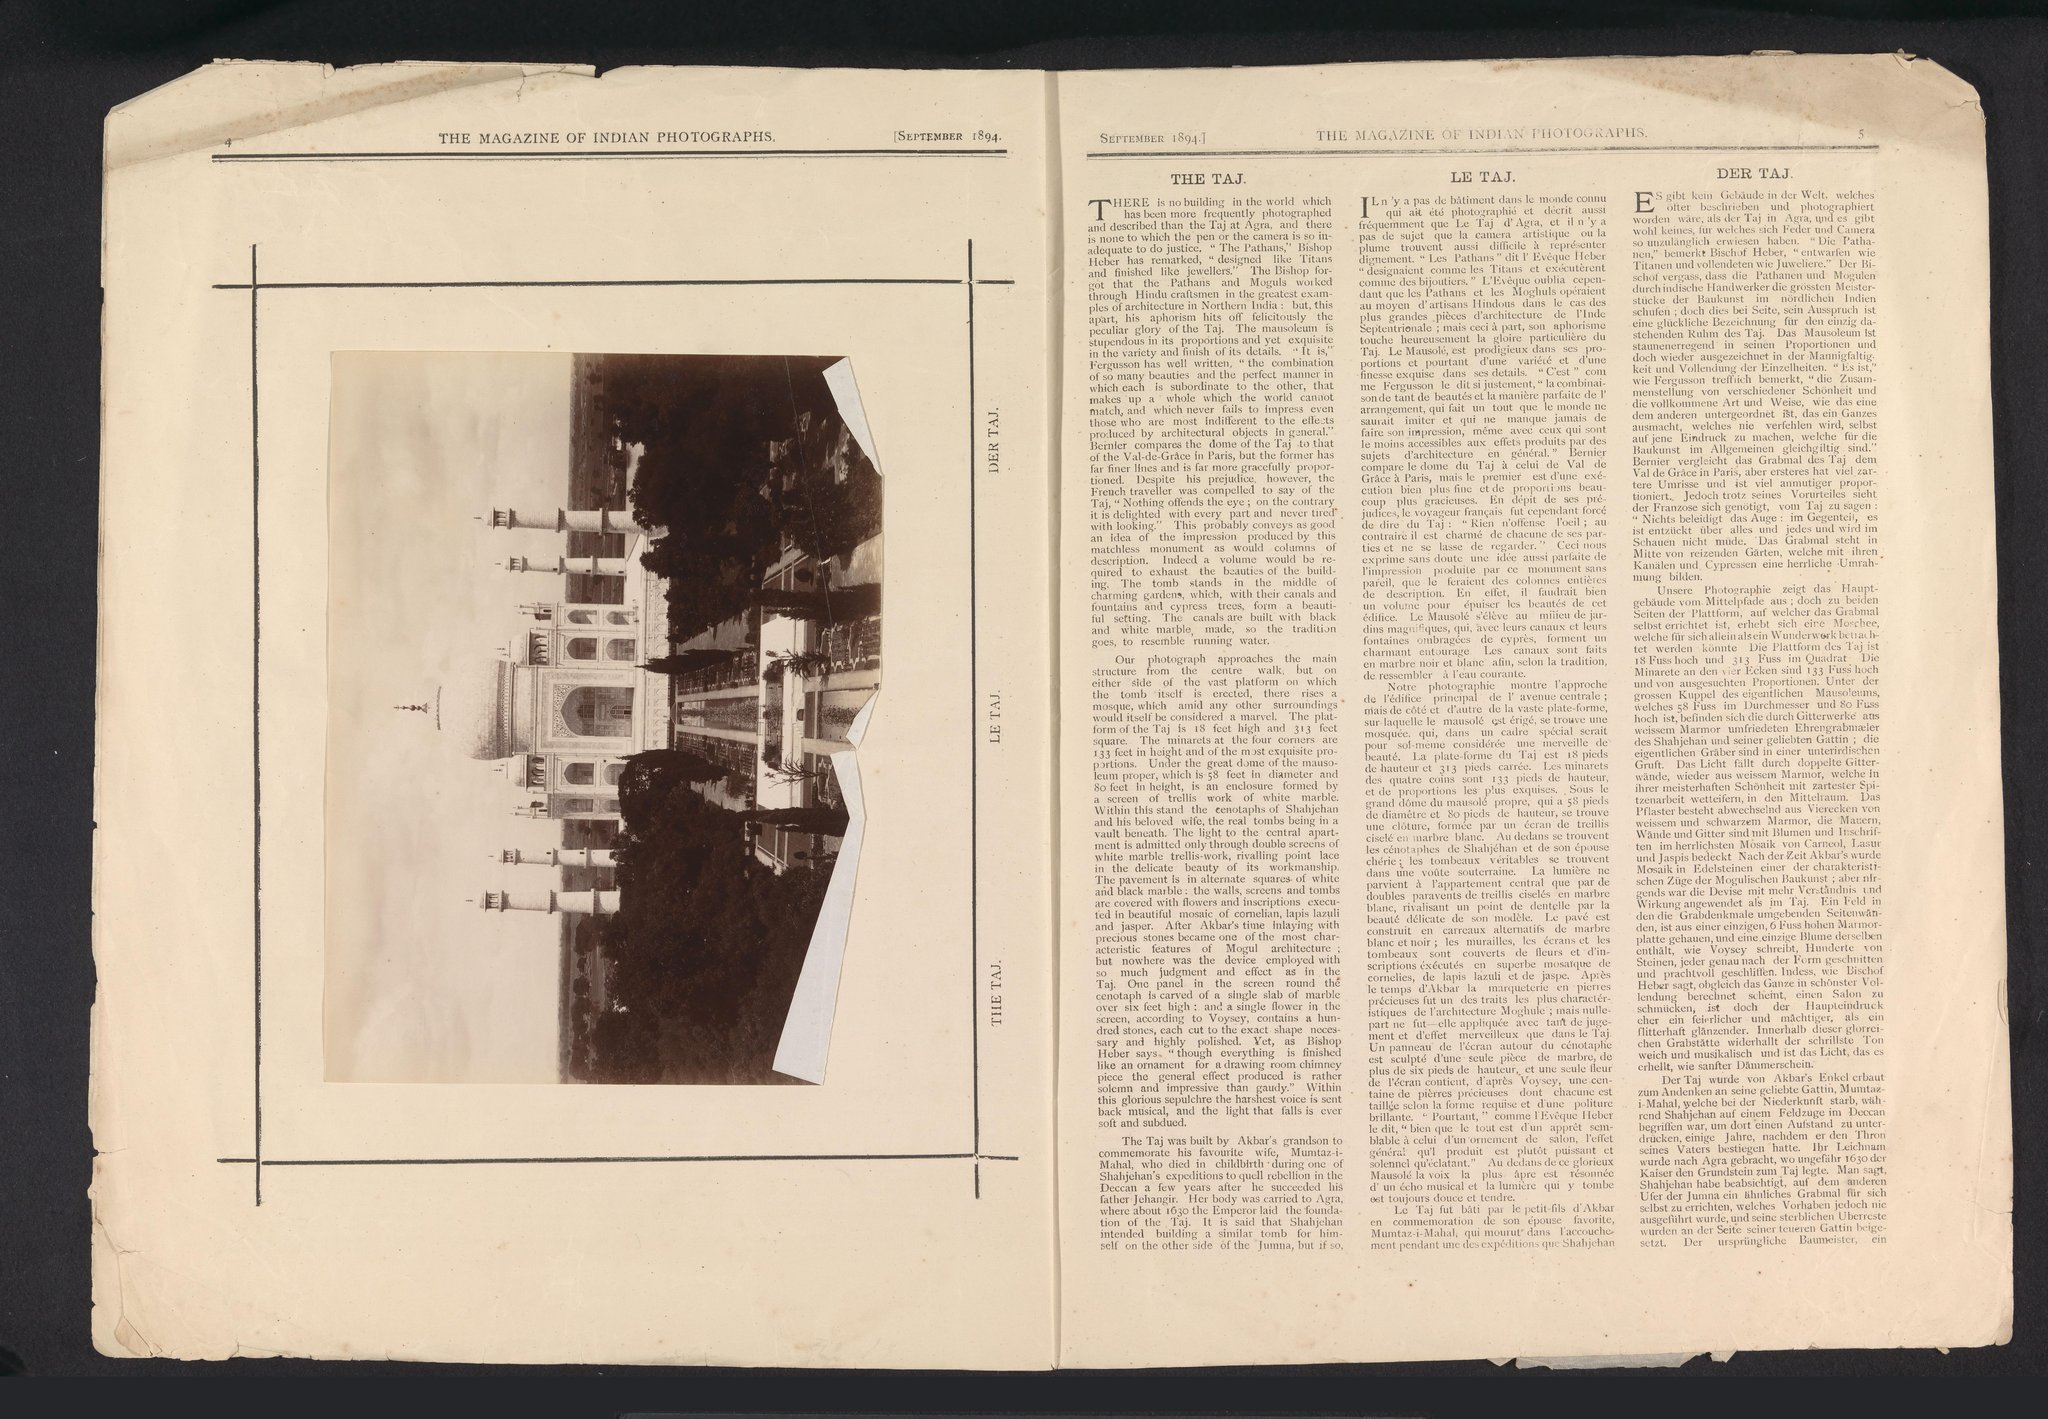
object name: photograph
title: View of the Taj Mahal at Agra, Uttar Pradesh, India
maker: Anonymous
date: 1889-1894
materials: photographic support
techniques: albumen print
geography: agra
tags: mausoleum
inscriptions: title: ‘THE TAJ. LE TAJ. DER TAJ.’